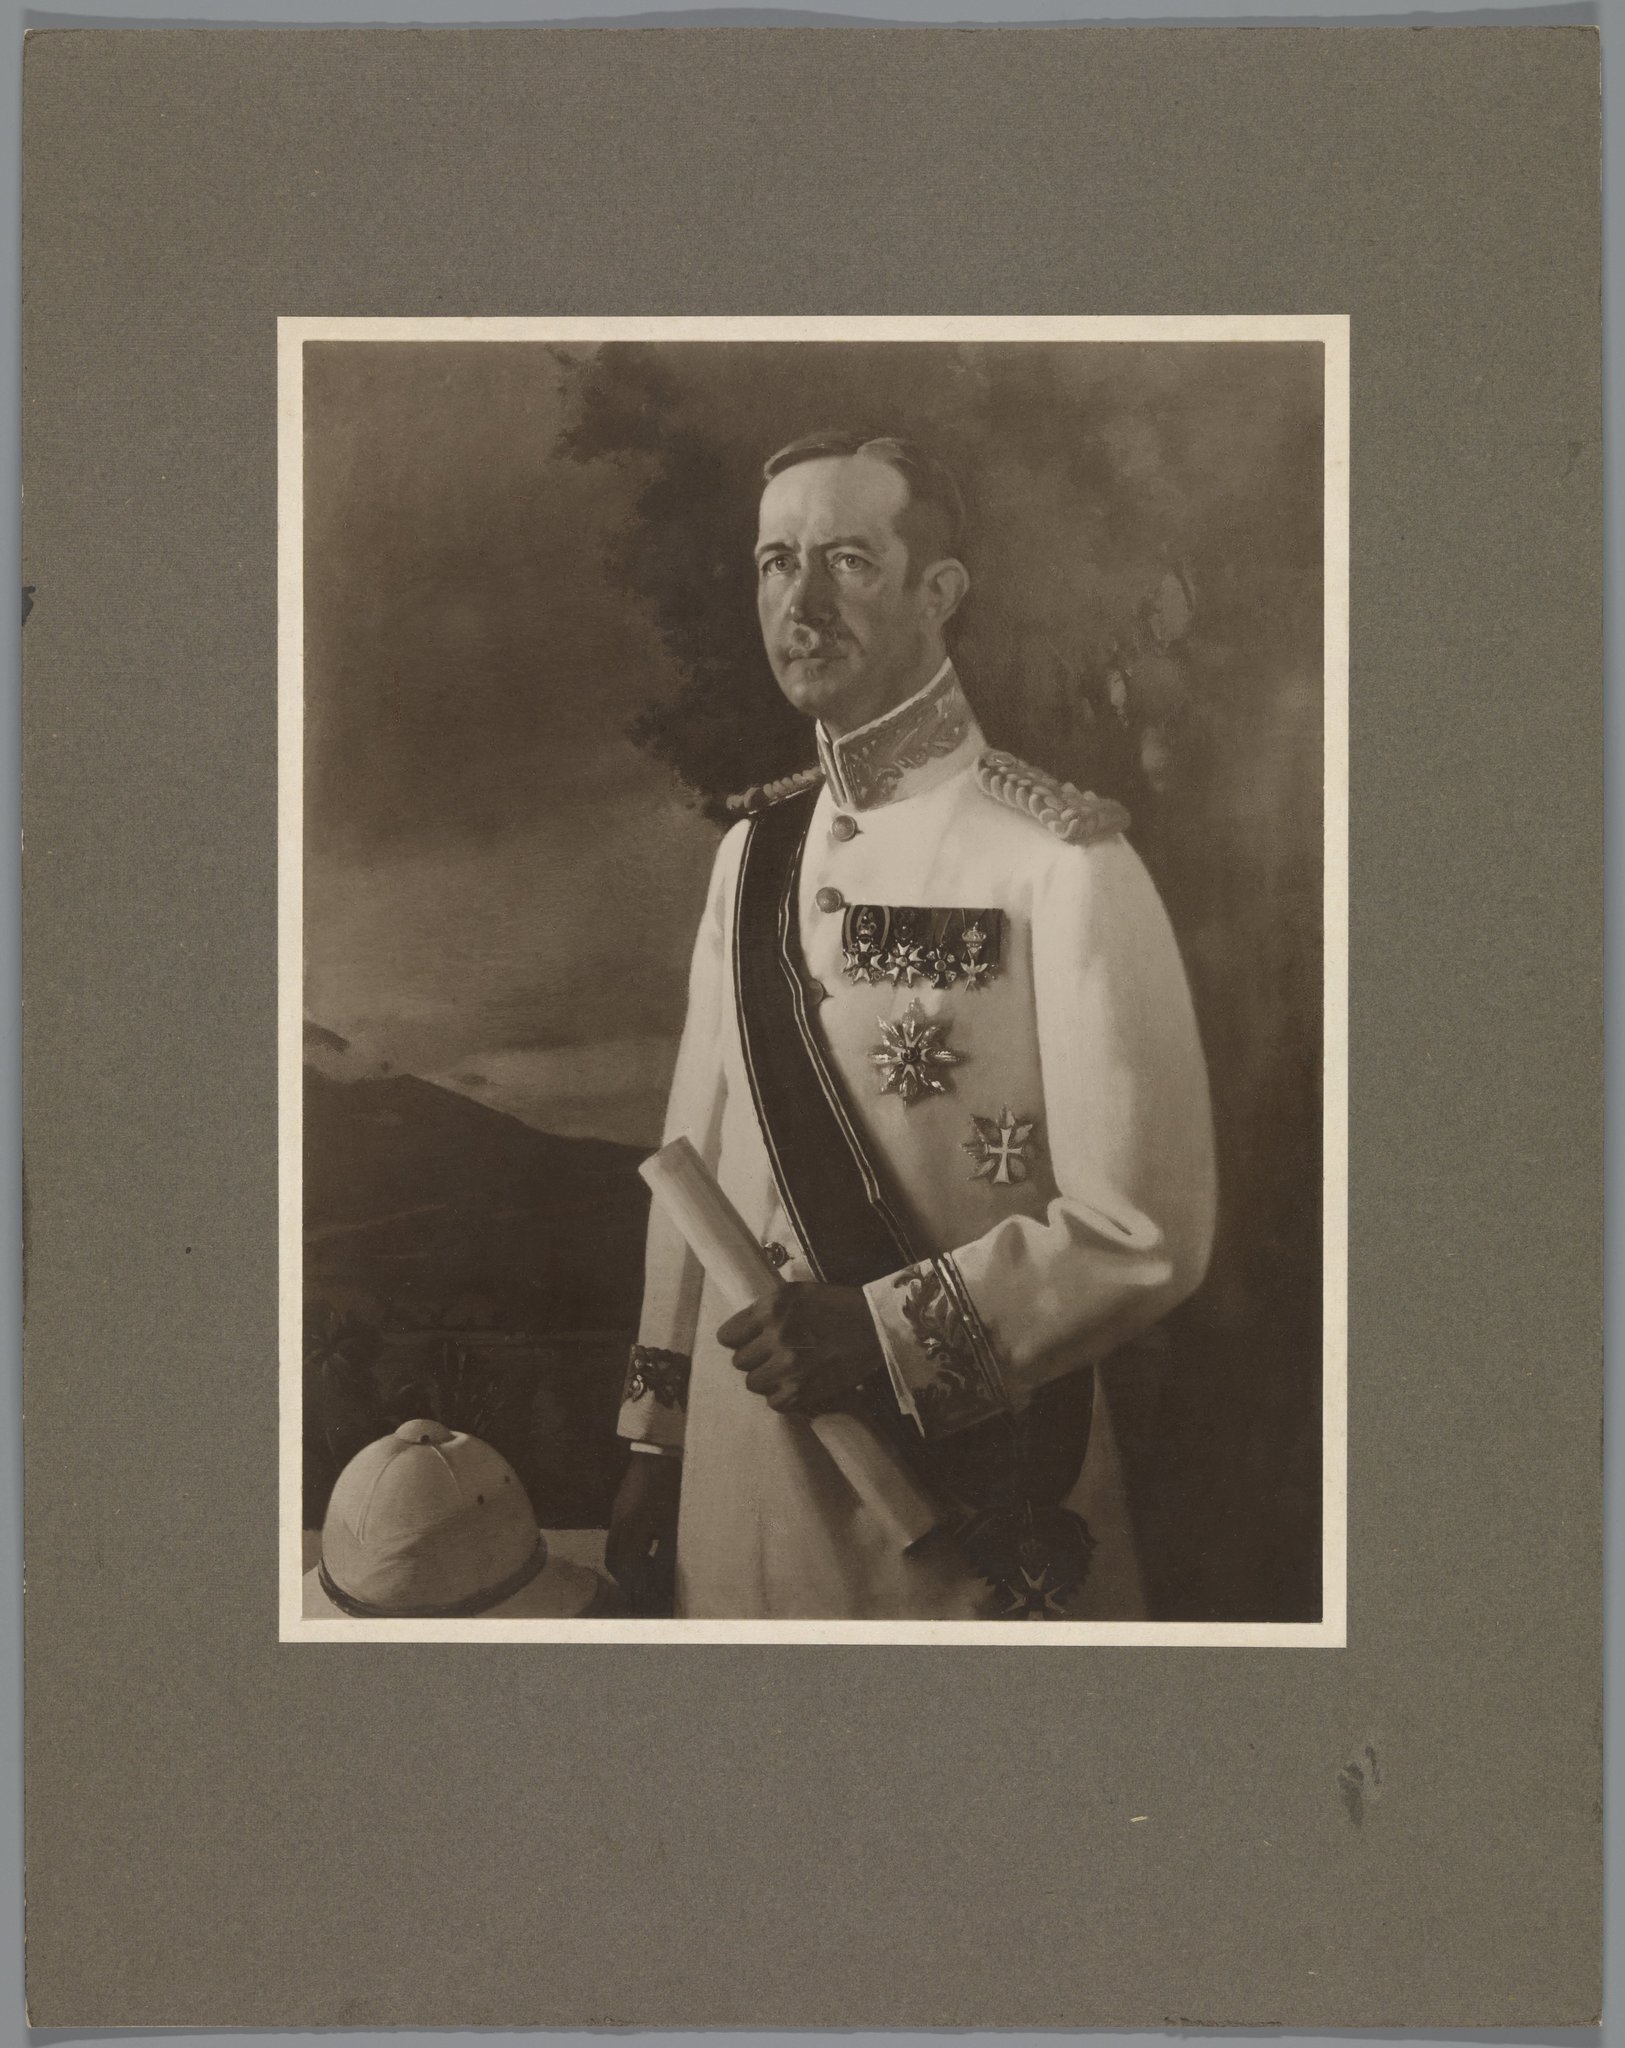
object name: photograph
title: Reproductie naar een verdwenen schilderij van Willem Witsen van een portret van J.P. van Limburg-Stirum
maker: Anonymous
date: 1860-1915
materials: cardboard, paper, photographic support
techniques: gelatin silver print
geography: netherlands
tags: the hague